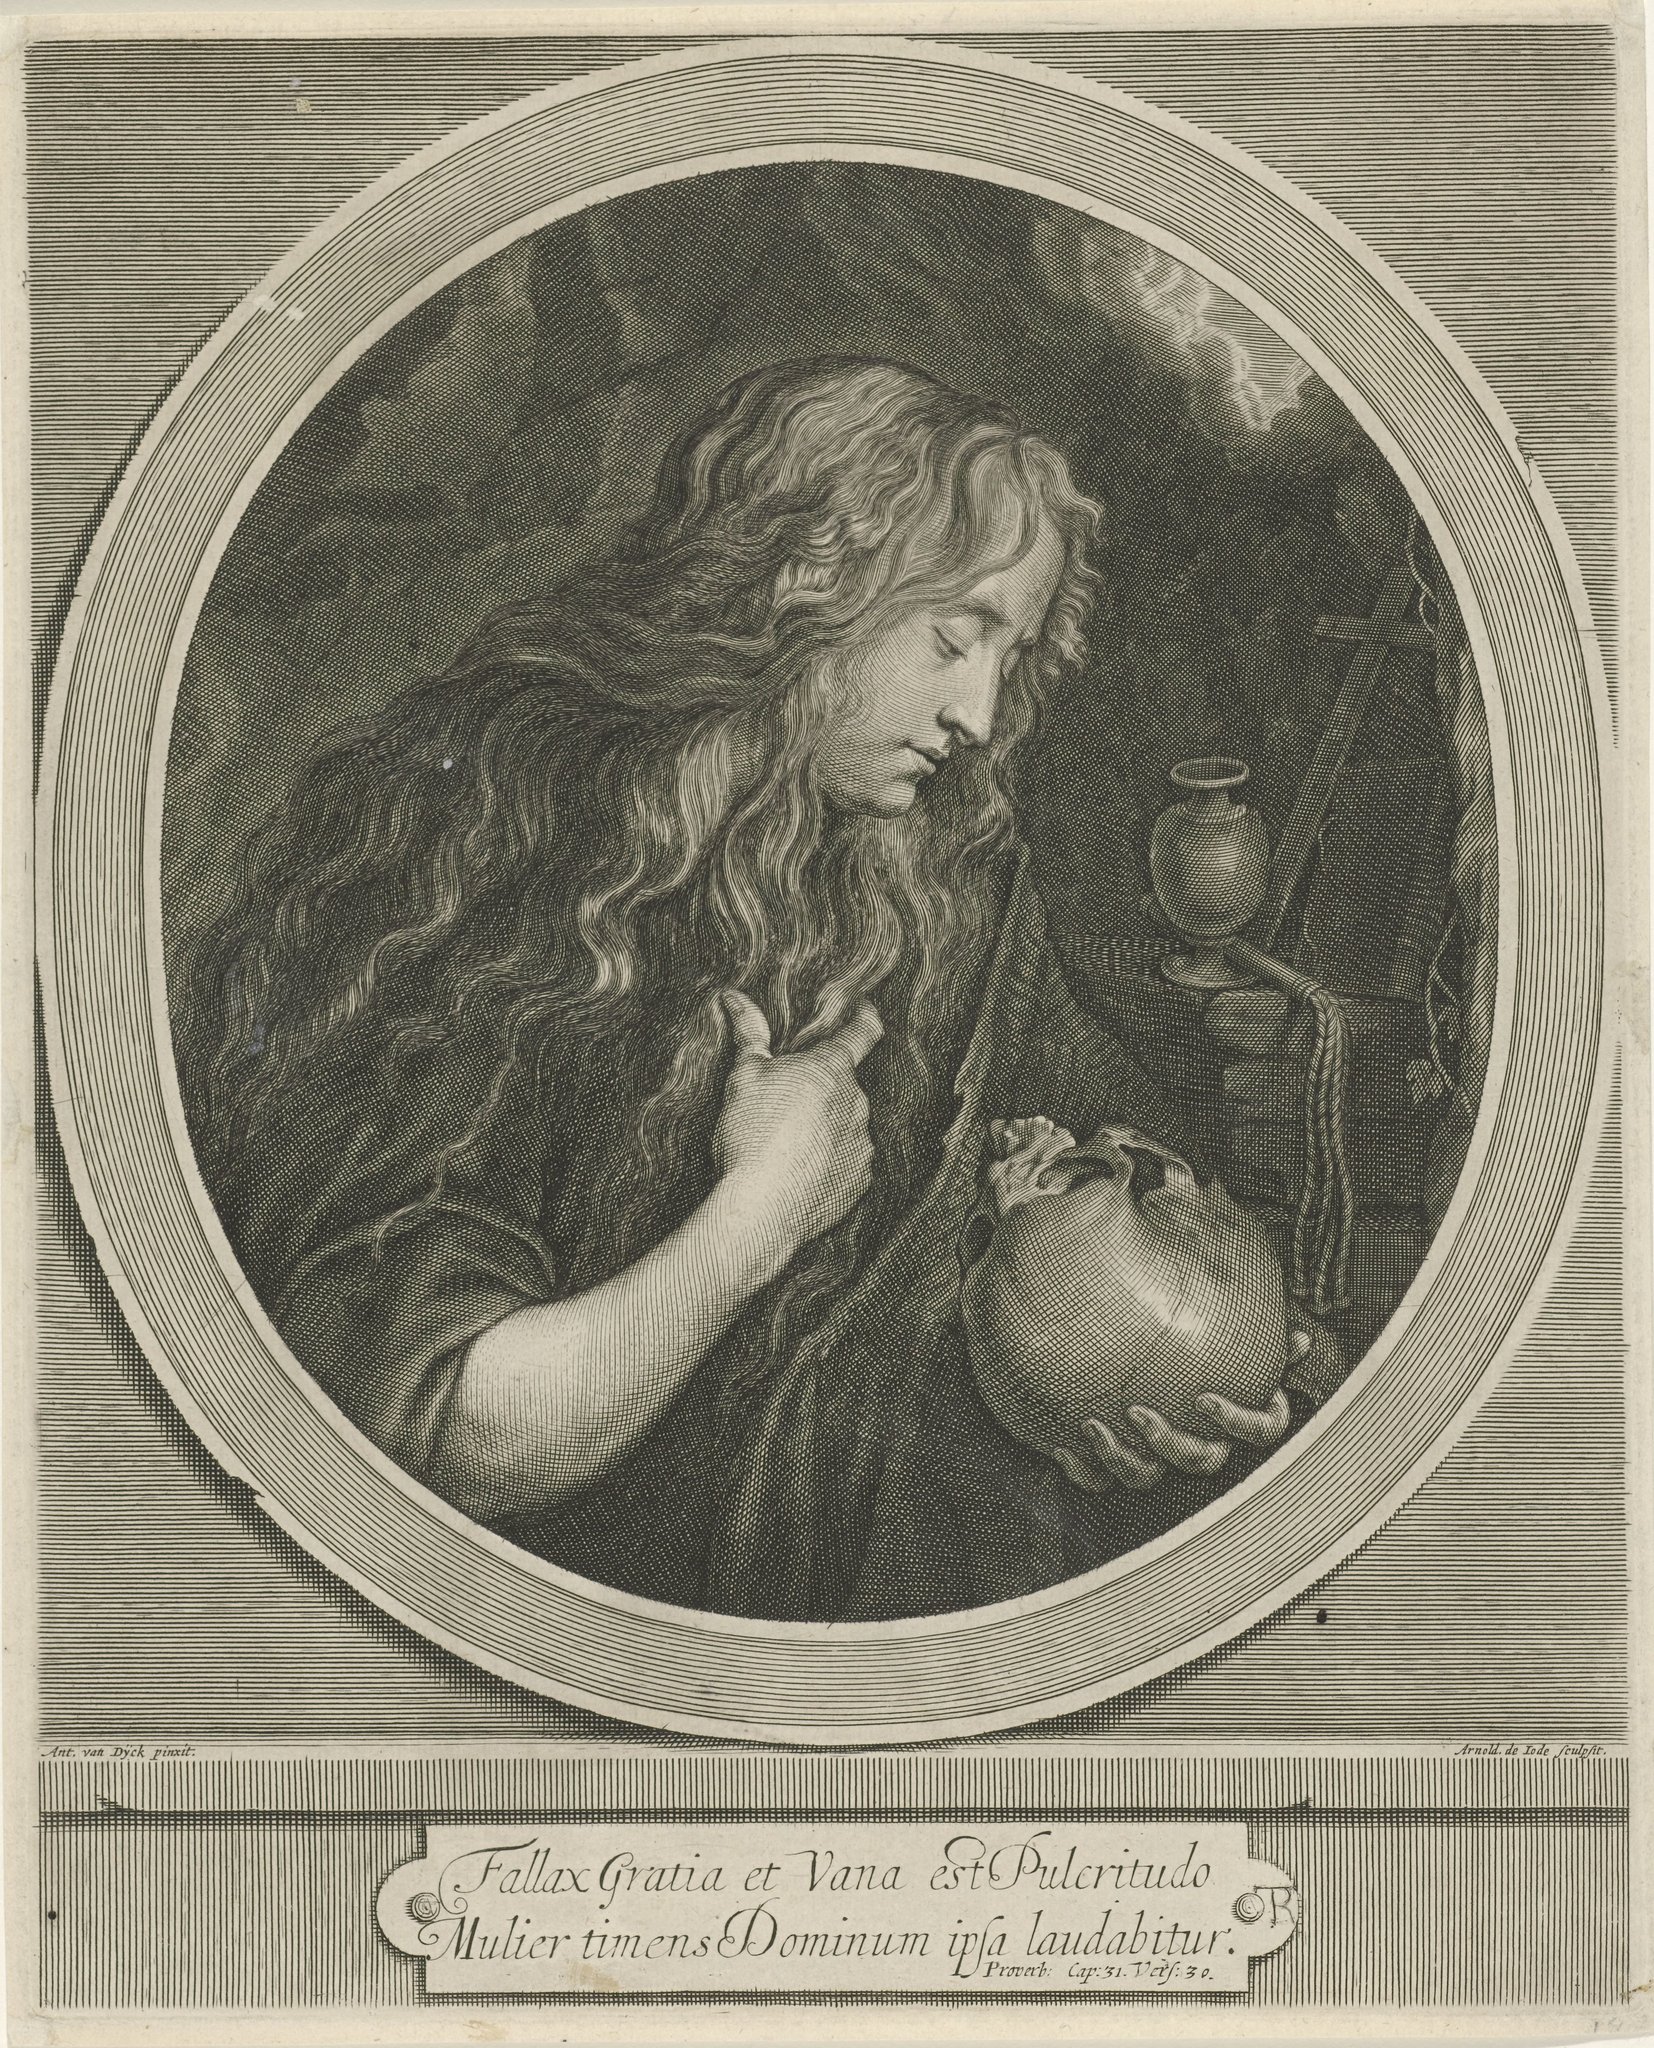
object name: print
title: Maria Magdalena met schedel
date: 1666-1669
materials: paper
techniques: engraving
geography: london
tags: the penitent harlot mary magdalene; possible attributes: book (or scroll), crown, crown of thorns, crucifix, jar of ointment, mirror, musical instrument, palm-branch, rosary, scourge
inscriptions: collector's mark: Lugt 240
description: De boetvaardige Maria Magdalena, schedel in de hand. Op de achtergrond haar attributen. In de cartouche een tweeregelig Bijbelcitaat uit Spr. 31:30 in het Latijn.